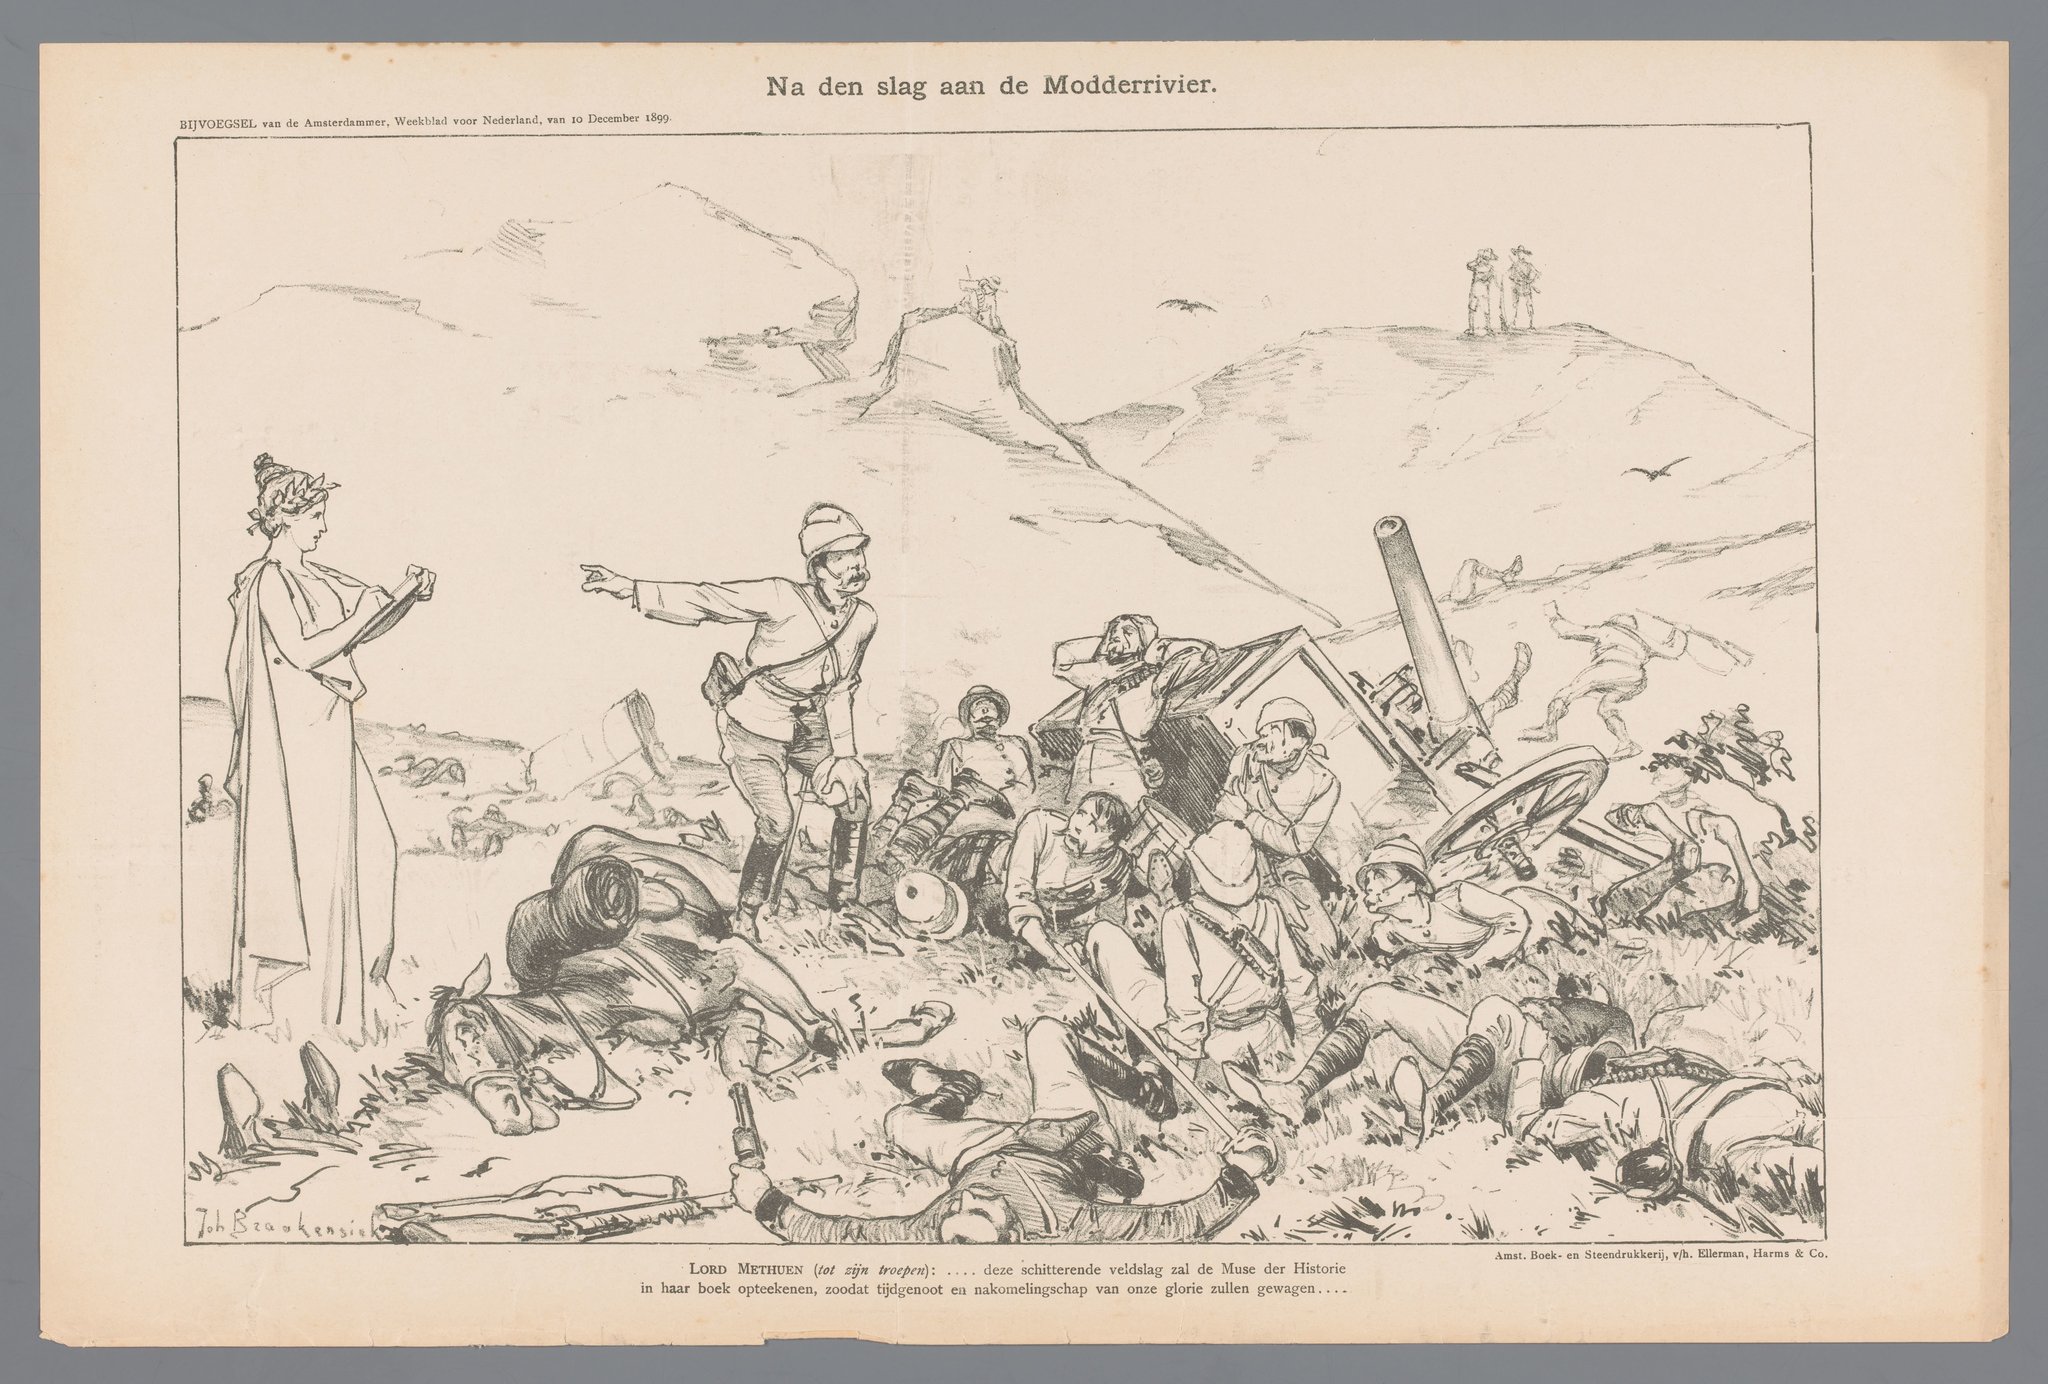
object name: cartoon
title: Na den slag aan de Modderrivier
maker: johan braakensiek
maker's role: draughtsman, print maker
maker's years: 1858-1940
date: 1899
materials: paper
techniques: lithograph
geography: amsterdam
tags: war, political caricatures and satires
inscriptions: date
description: Prent uit het bijvoegsel van: De Amsterdammer. Weekblad voor Nederland, 10 december 1899.